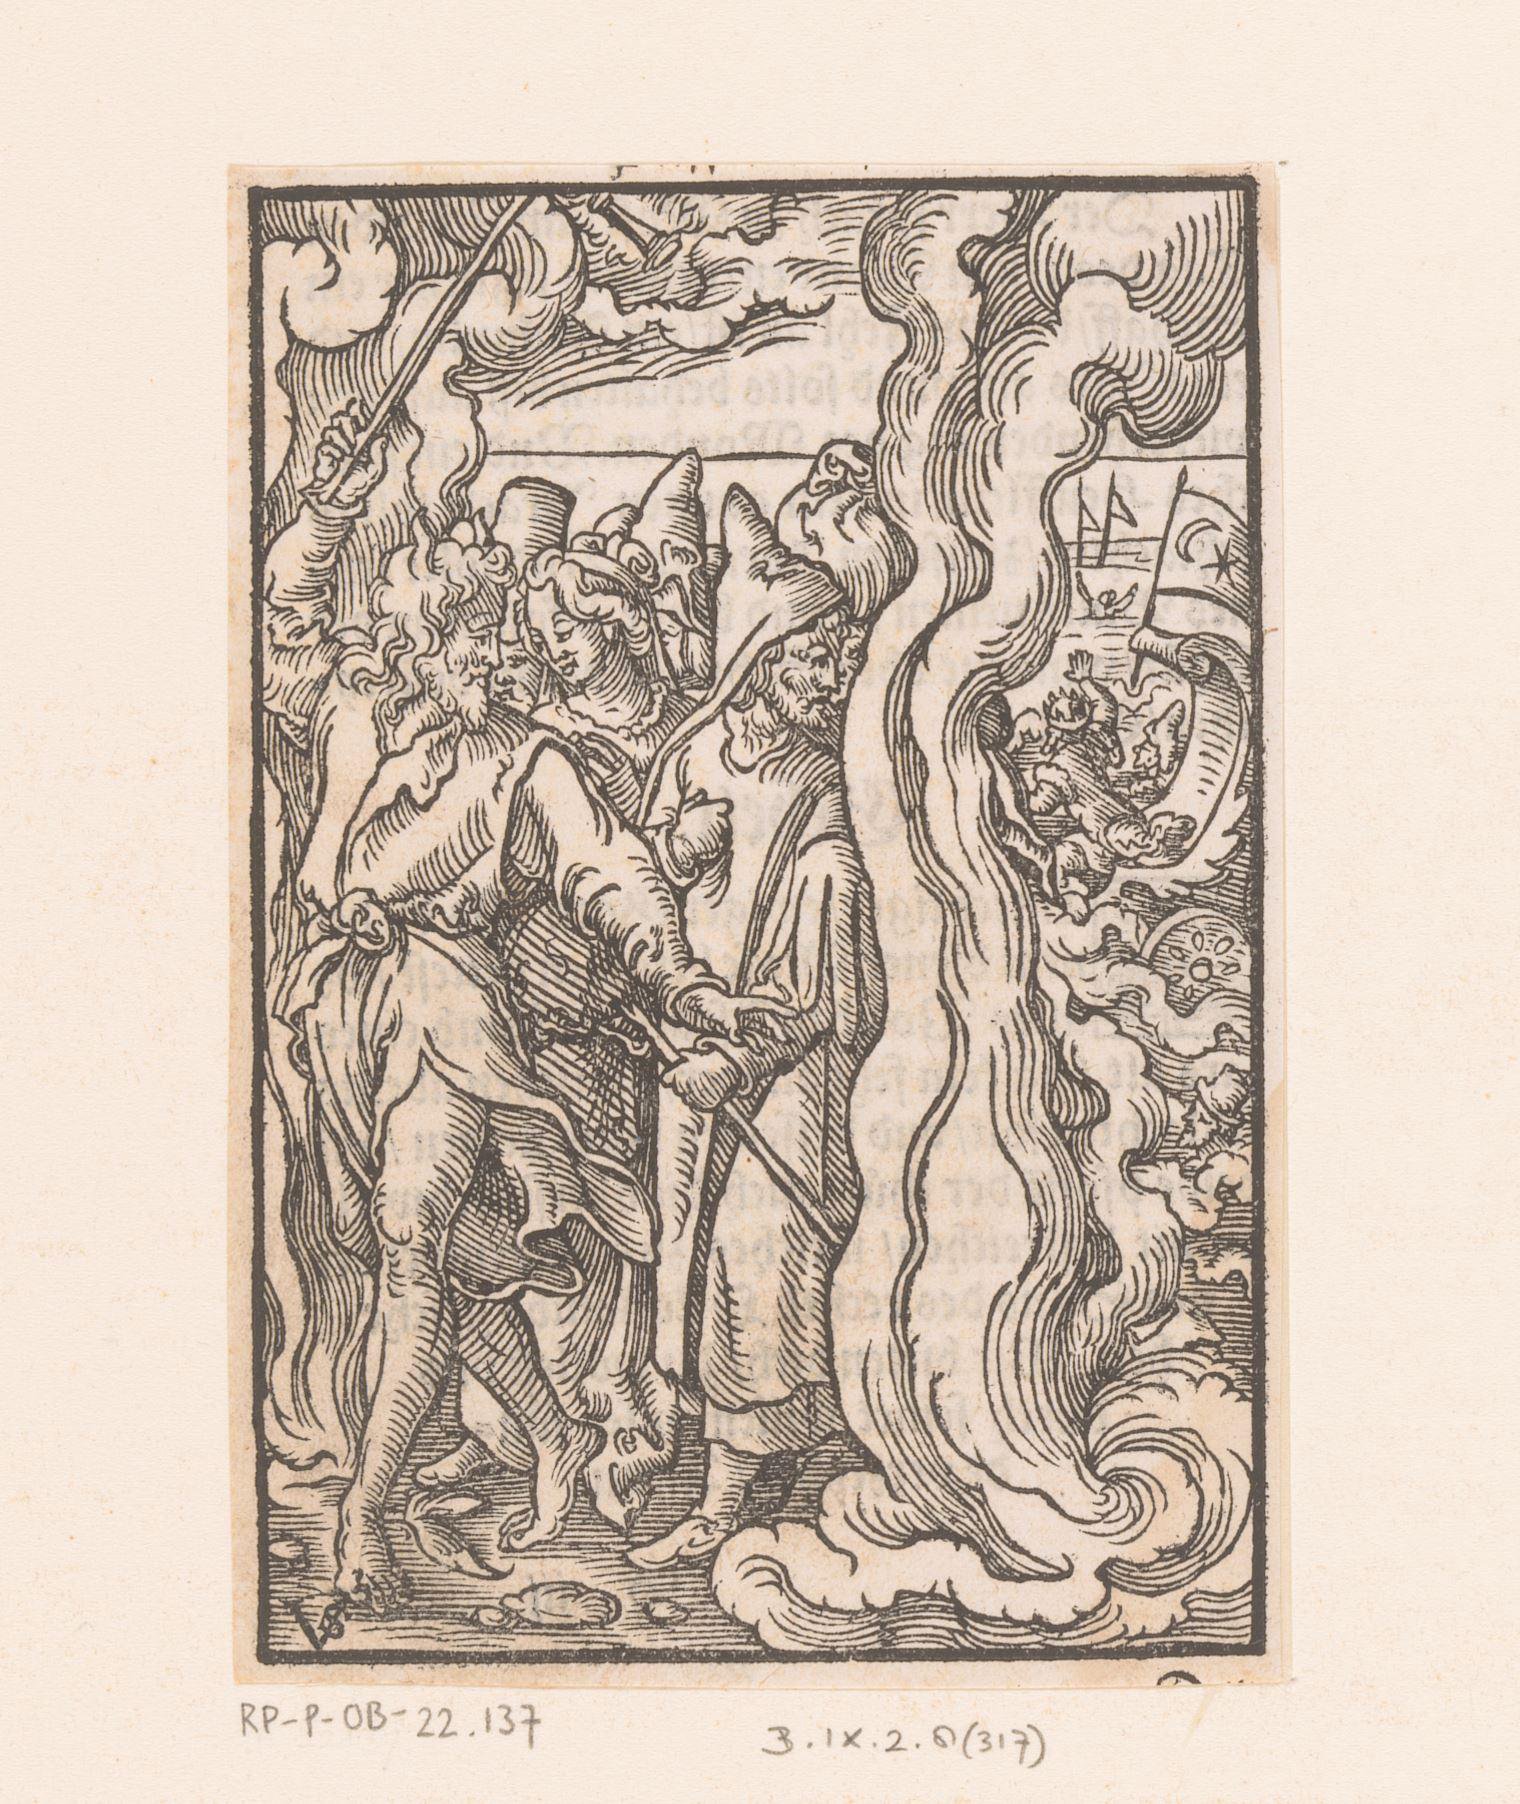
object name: book illustration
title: Egyptenaren verdrinken in de Schelfzee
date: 1552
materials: paper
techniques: woodcut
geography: nuremberg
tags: with his people safe on the shore, moses raises his hands and causes the water to return; pharaoh's army perishes in the water (red sea)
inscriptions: number: ‘181’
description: Gebruikt voor verschillende publicaties die werden gedrukt door Valentin Geißler tussen 1552 en 1560 te Neurenberg.